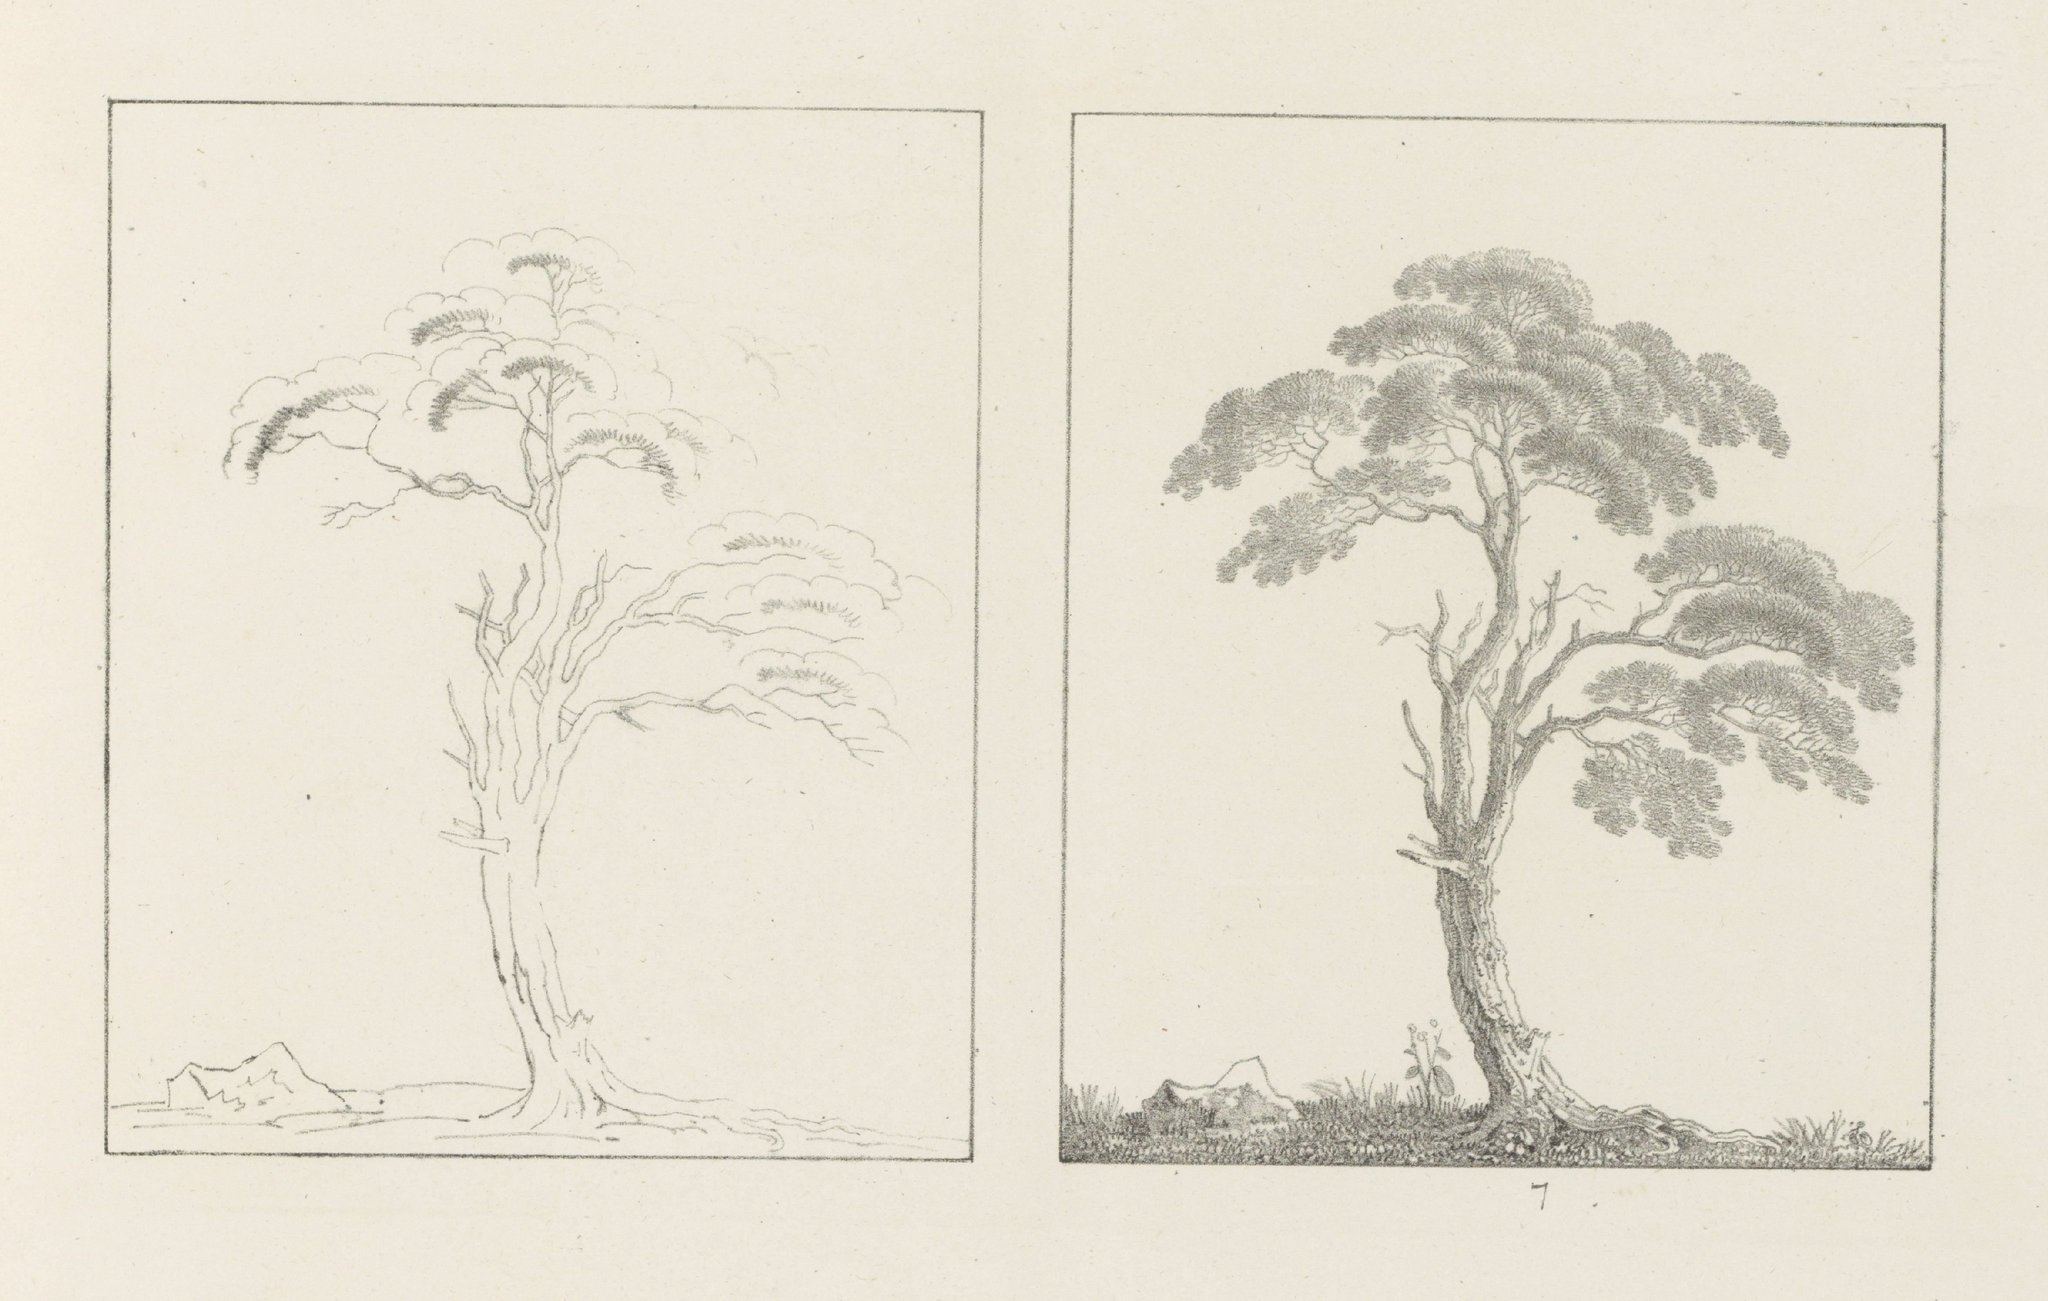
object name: print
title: Albumblad met twee voorstellingen van twee bomen: links het ontwerp, rechts de uitvoering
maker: max josef wagenbauer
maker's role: print maker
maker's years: 1774-1829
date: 1816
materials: paper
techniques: lithograph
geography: munich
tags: trees, the graphic arts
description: Albumblad met twee voorstellingen van twee bomen: links het ontwerp, rechts de uitvoering. Maakt deel uit van een album met 18 bladen met studies van bomen.